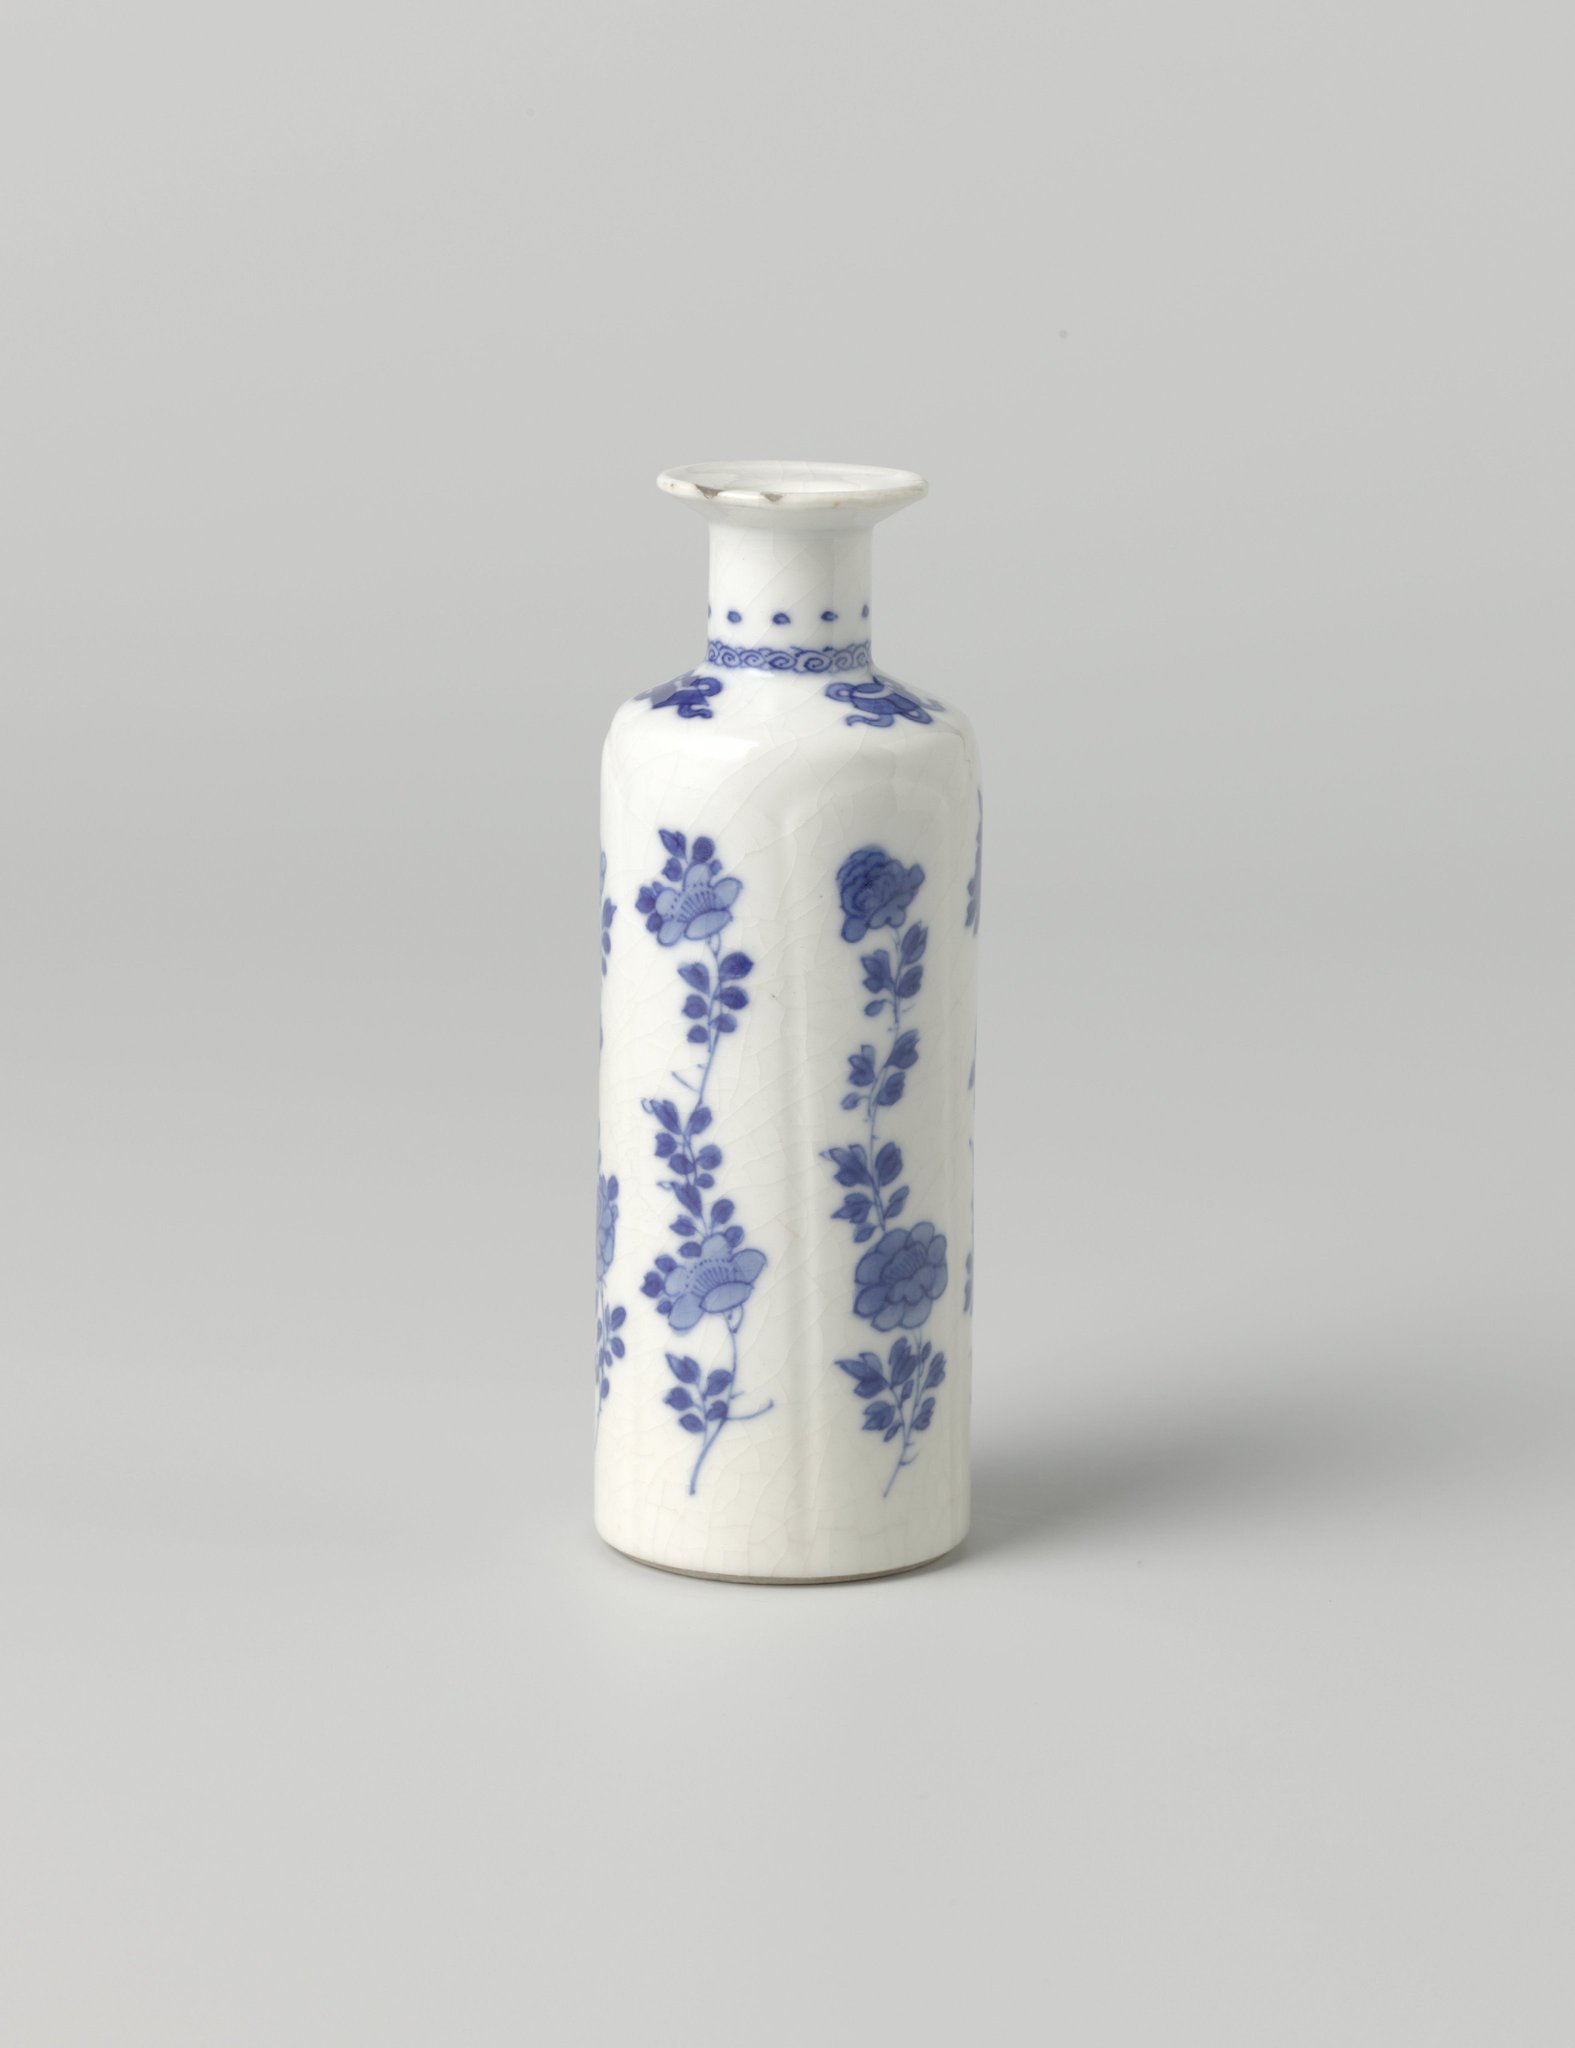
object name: bottle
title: Small, cylindrical bottle vase with flower sprays and precious objects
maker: Anonymous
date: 1680-1720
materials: cobalt, glaze, paint, porcelain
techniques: firing, turning, vitrification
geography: china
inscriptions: mark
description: Kleine cilindrische, flesvormige vaas van porselein met rechte nek en en platte rand, beschilderd in onderglazuur blauw. De wand is gemodelleerd in zes vakken gevuld met een bloemtak; op de schouder kostbaarheden (parel, ruit, artemisiablad), op de nek een band met krulmotief en stippen. Gemerkt op de onderzijde met een Chinees karakter. Gecraqueleerd glazuur. Blauw-wit.